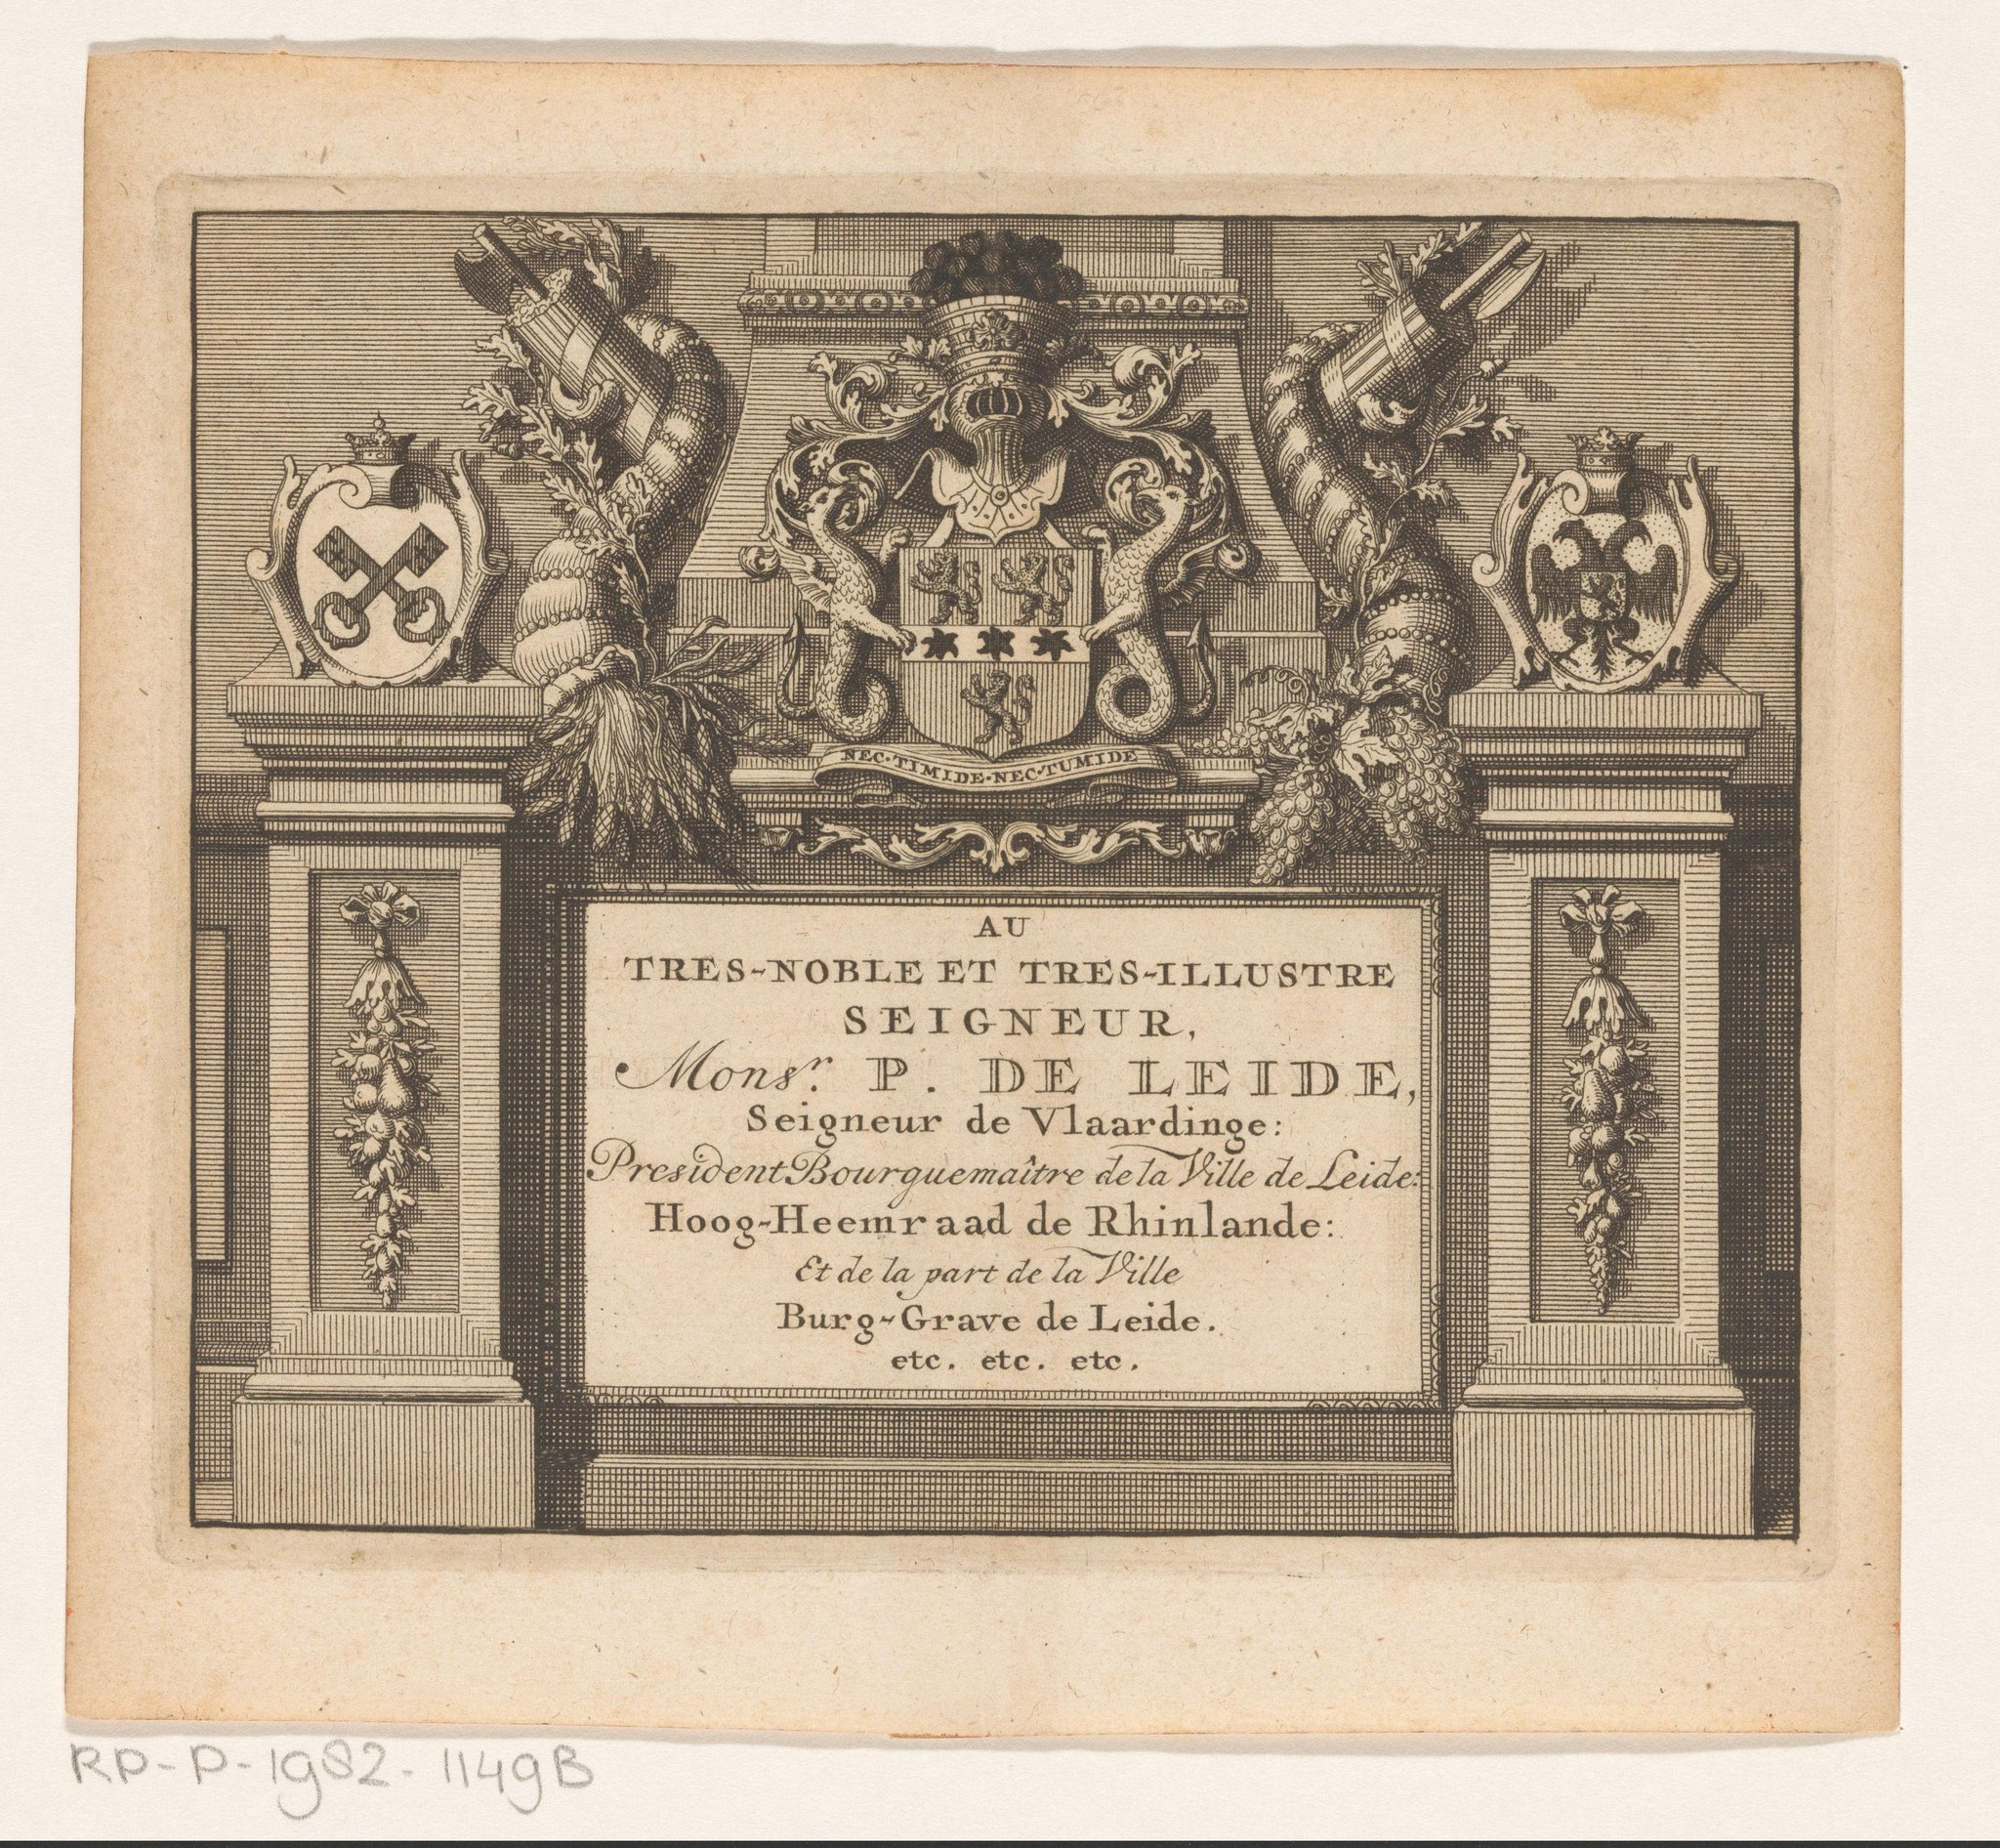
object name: book illustration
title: Monument met hoornen des overvloeds en wapenschilden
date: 1712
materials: paper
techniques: engraving, etching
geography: leiden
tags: mayor, pieter van leyden, coat of arms (as symbol of the state, etc.), 'cornucopia', horn of plenty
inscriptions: collector's mark: Lugt 2228, collector's mark: Lugt 2760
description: Monument met twee hoornen des overvloeds en drie wapenschilden. Daarbij een opdracht aan president burgemeester Pieter van Leyden, heer van Vlaardingen.